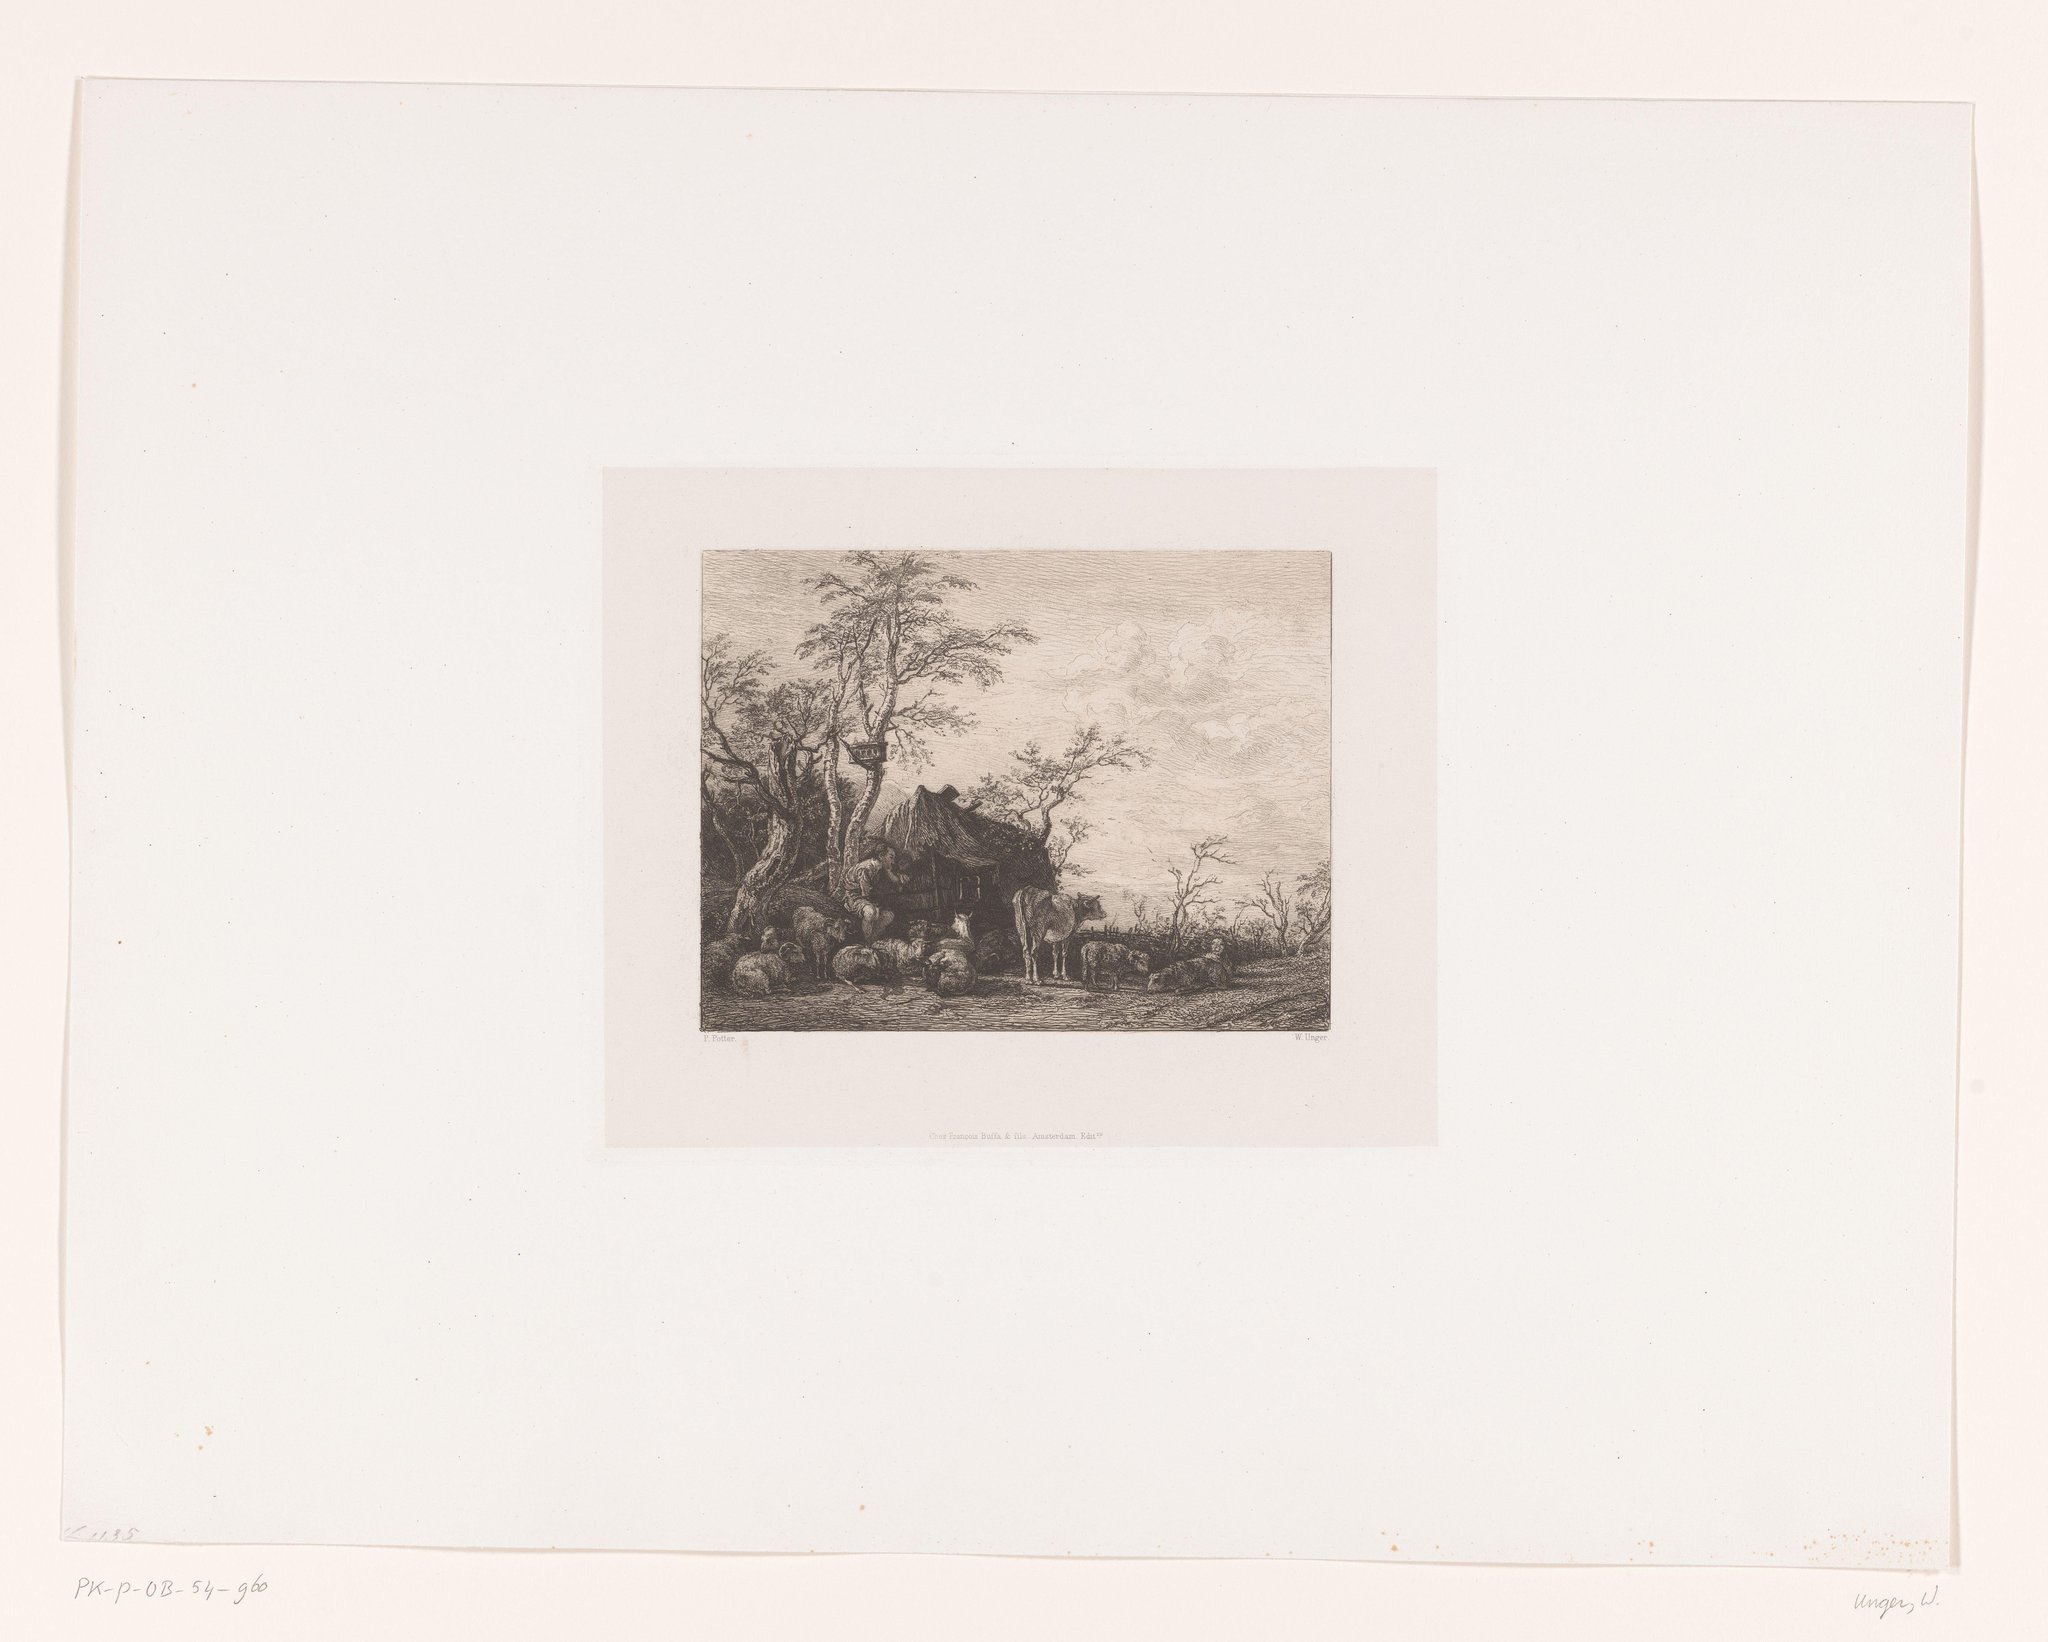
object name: print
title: Herdershut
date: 1847-1889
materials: paper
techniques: etching, intaglio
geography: amsterdam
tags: cow, herding, herdsman, herdswoman, shepherd, shepherdess, cowherd, etc., sheep